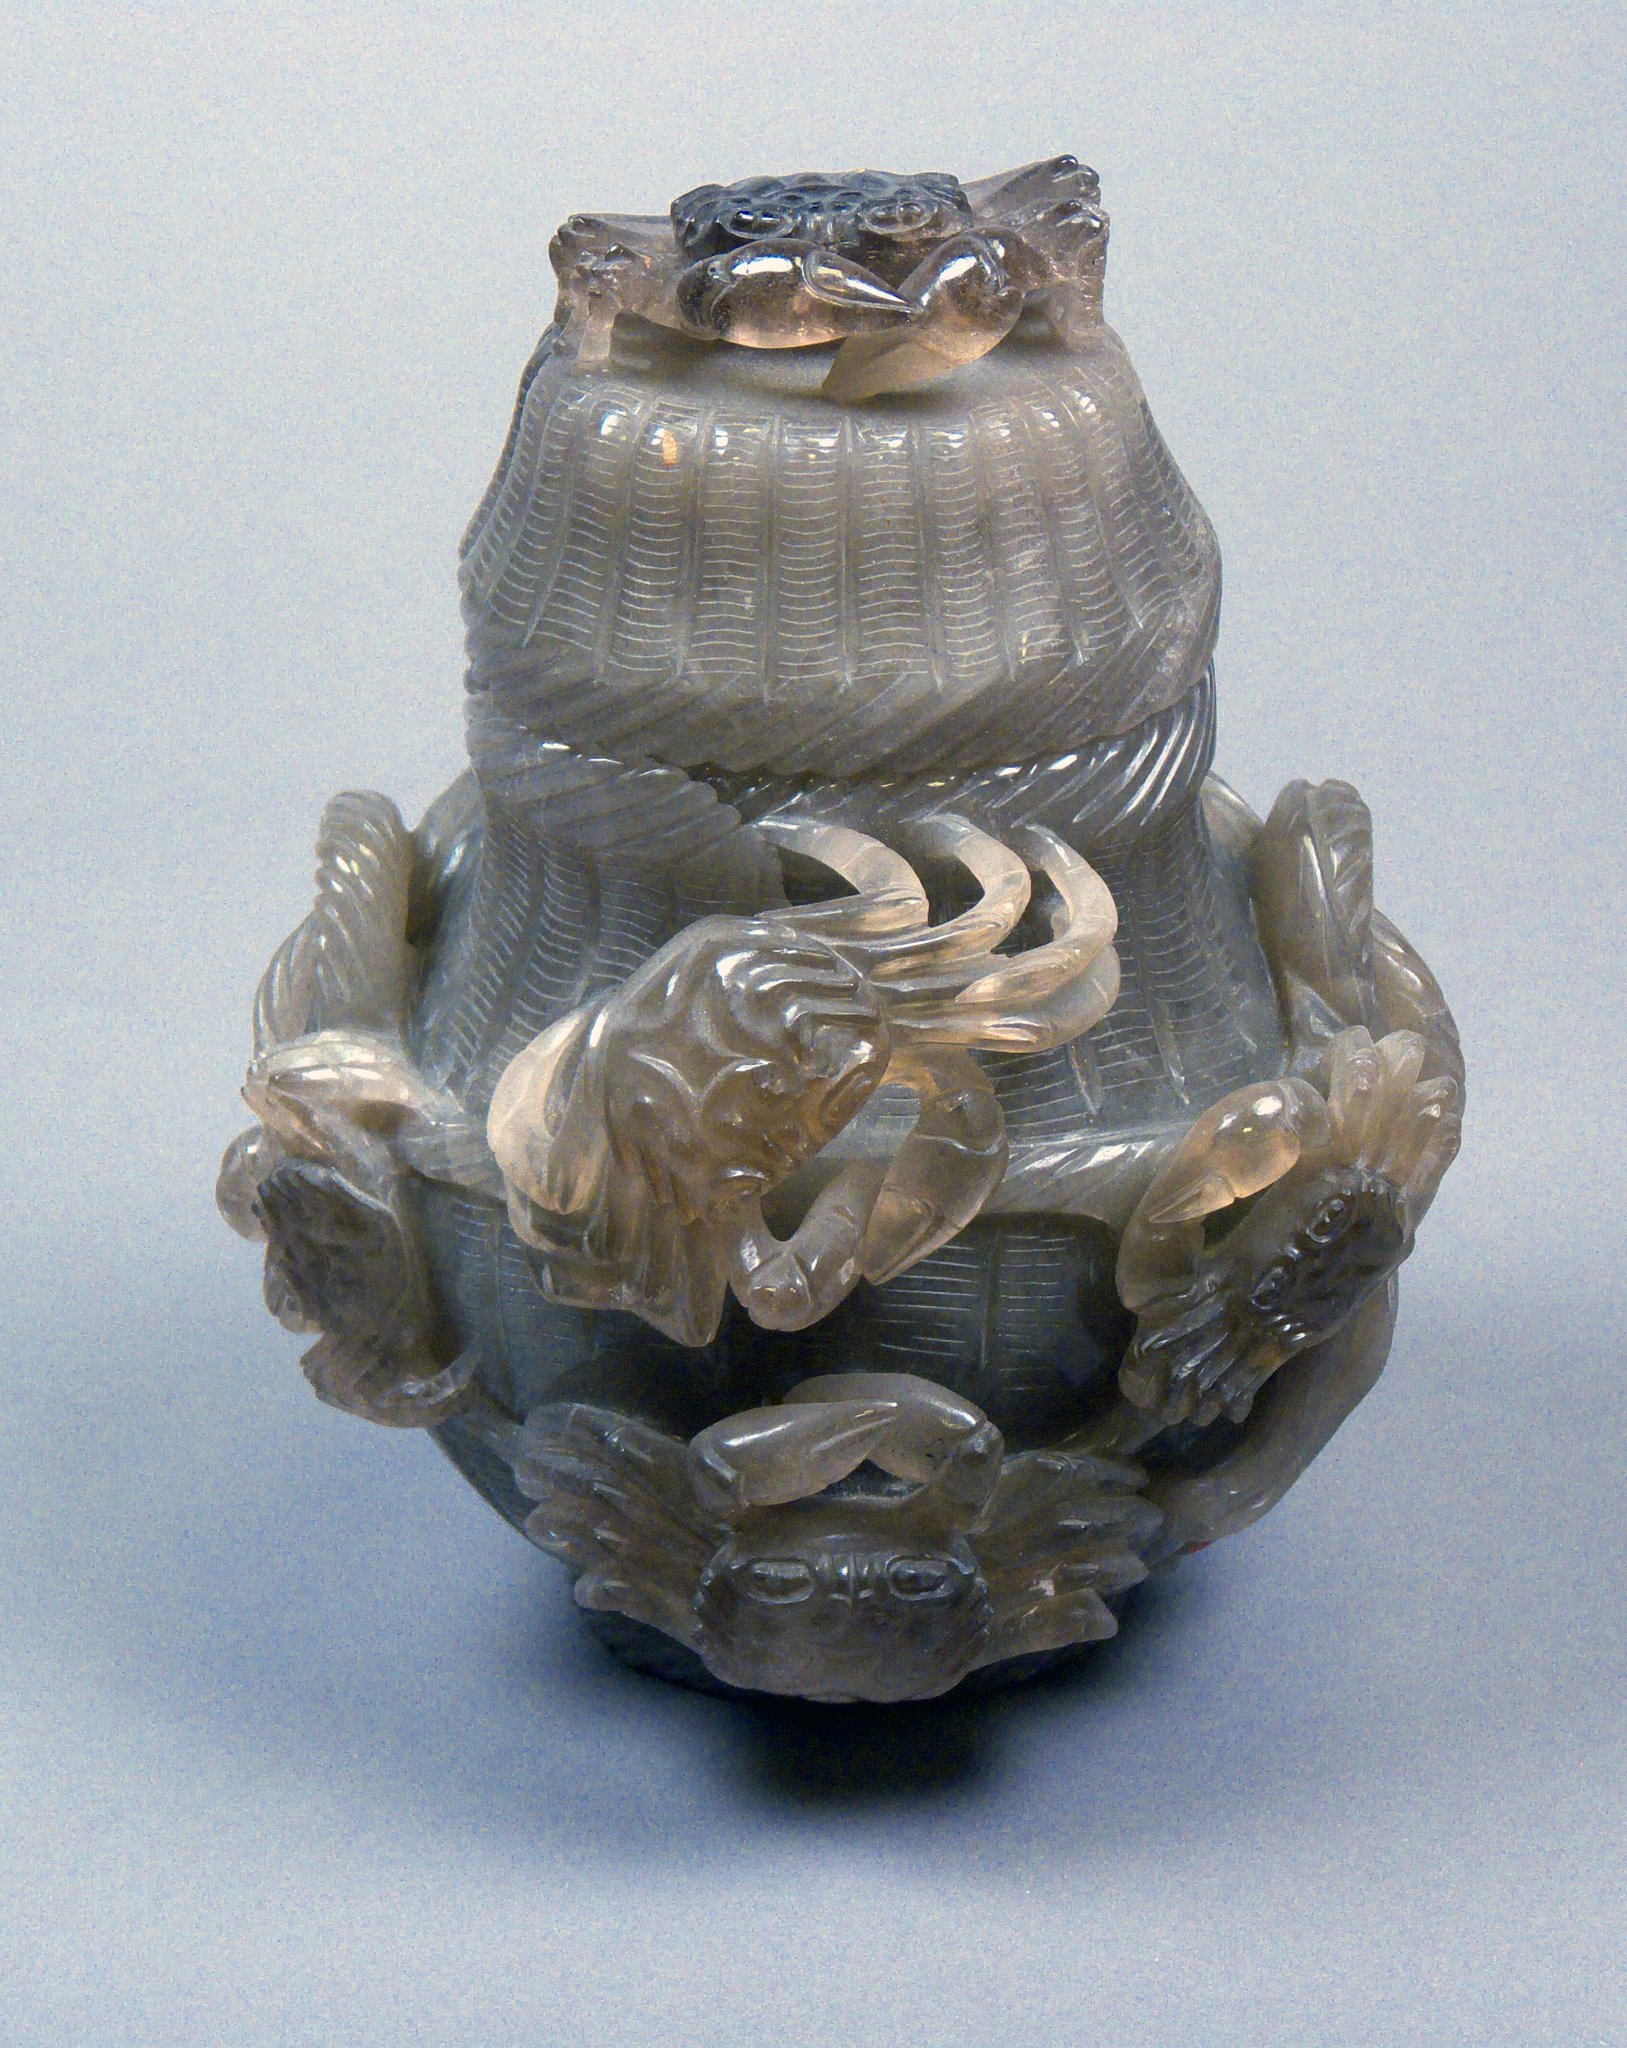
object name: covered vase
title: Basket with crabs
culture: chinese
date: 1644-1911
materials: gemstone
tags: crabs